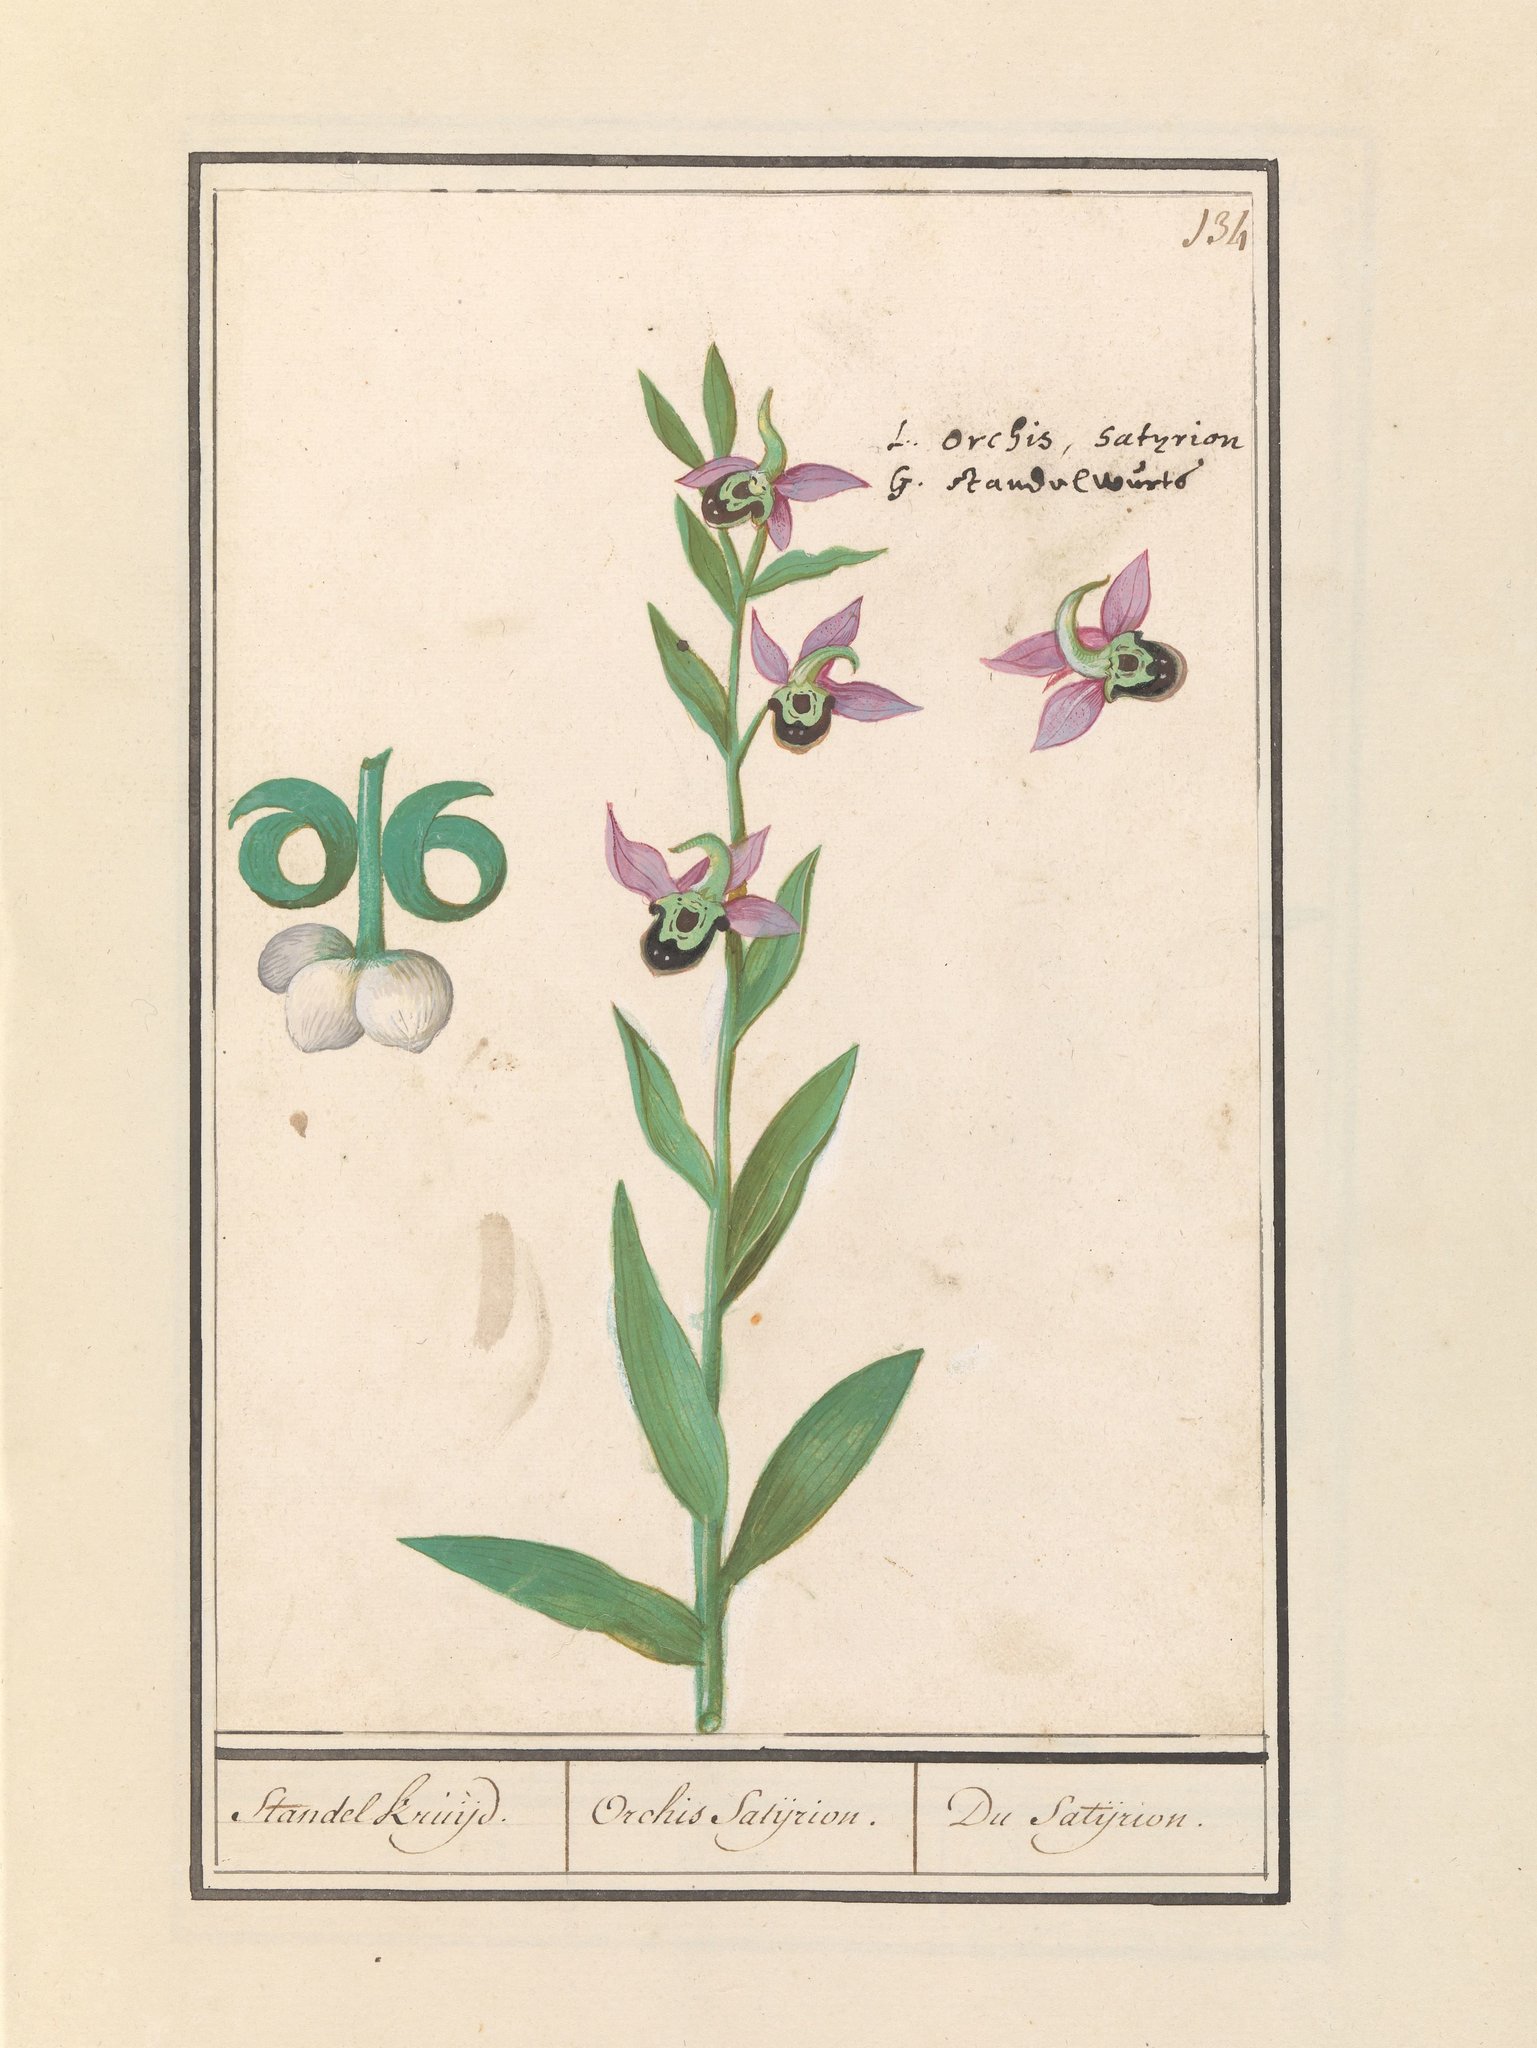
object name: drawing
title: Laughing Bumblebee Orchid (Ophrys bombyliflora)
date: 1596-1610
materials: chalk, paint, ink, paper, watercolor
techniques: brush, pen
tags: flowers: orchid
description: The Historia Naturalis aimed to give a reliable ‘scientific’ image for each subject. However, you might well wonder about this image. At first glance, green heads of birds or ducks – hidden behind coats of arms – seem to hang from a stem. Yet here, too, the artist followed reality fairly closely. We are again witnessing one of Nature’s little jokes.